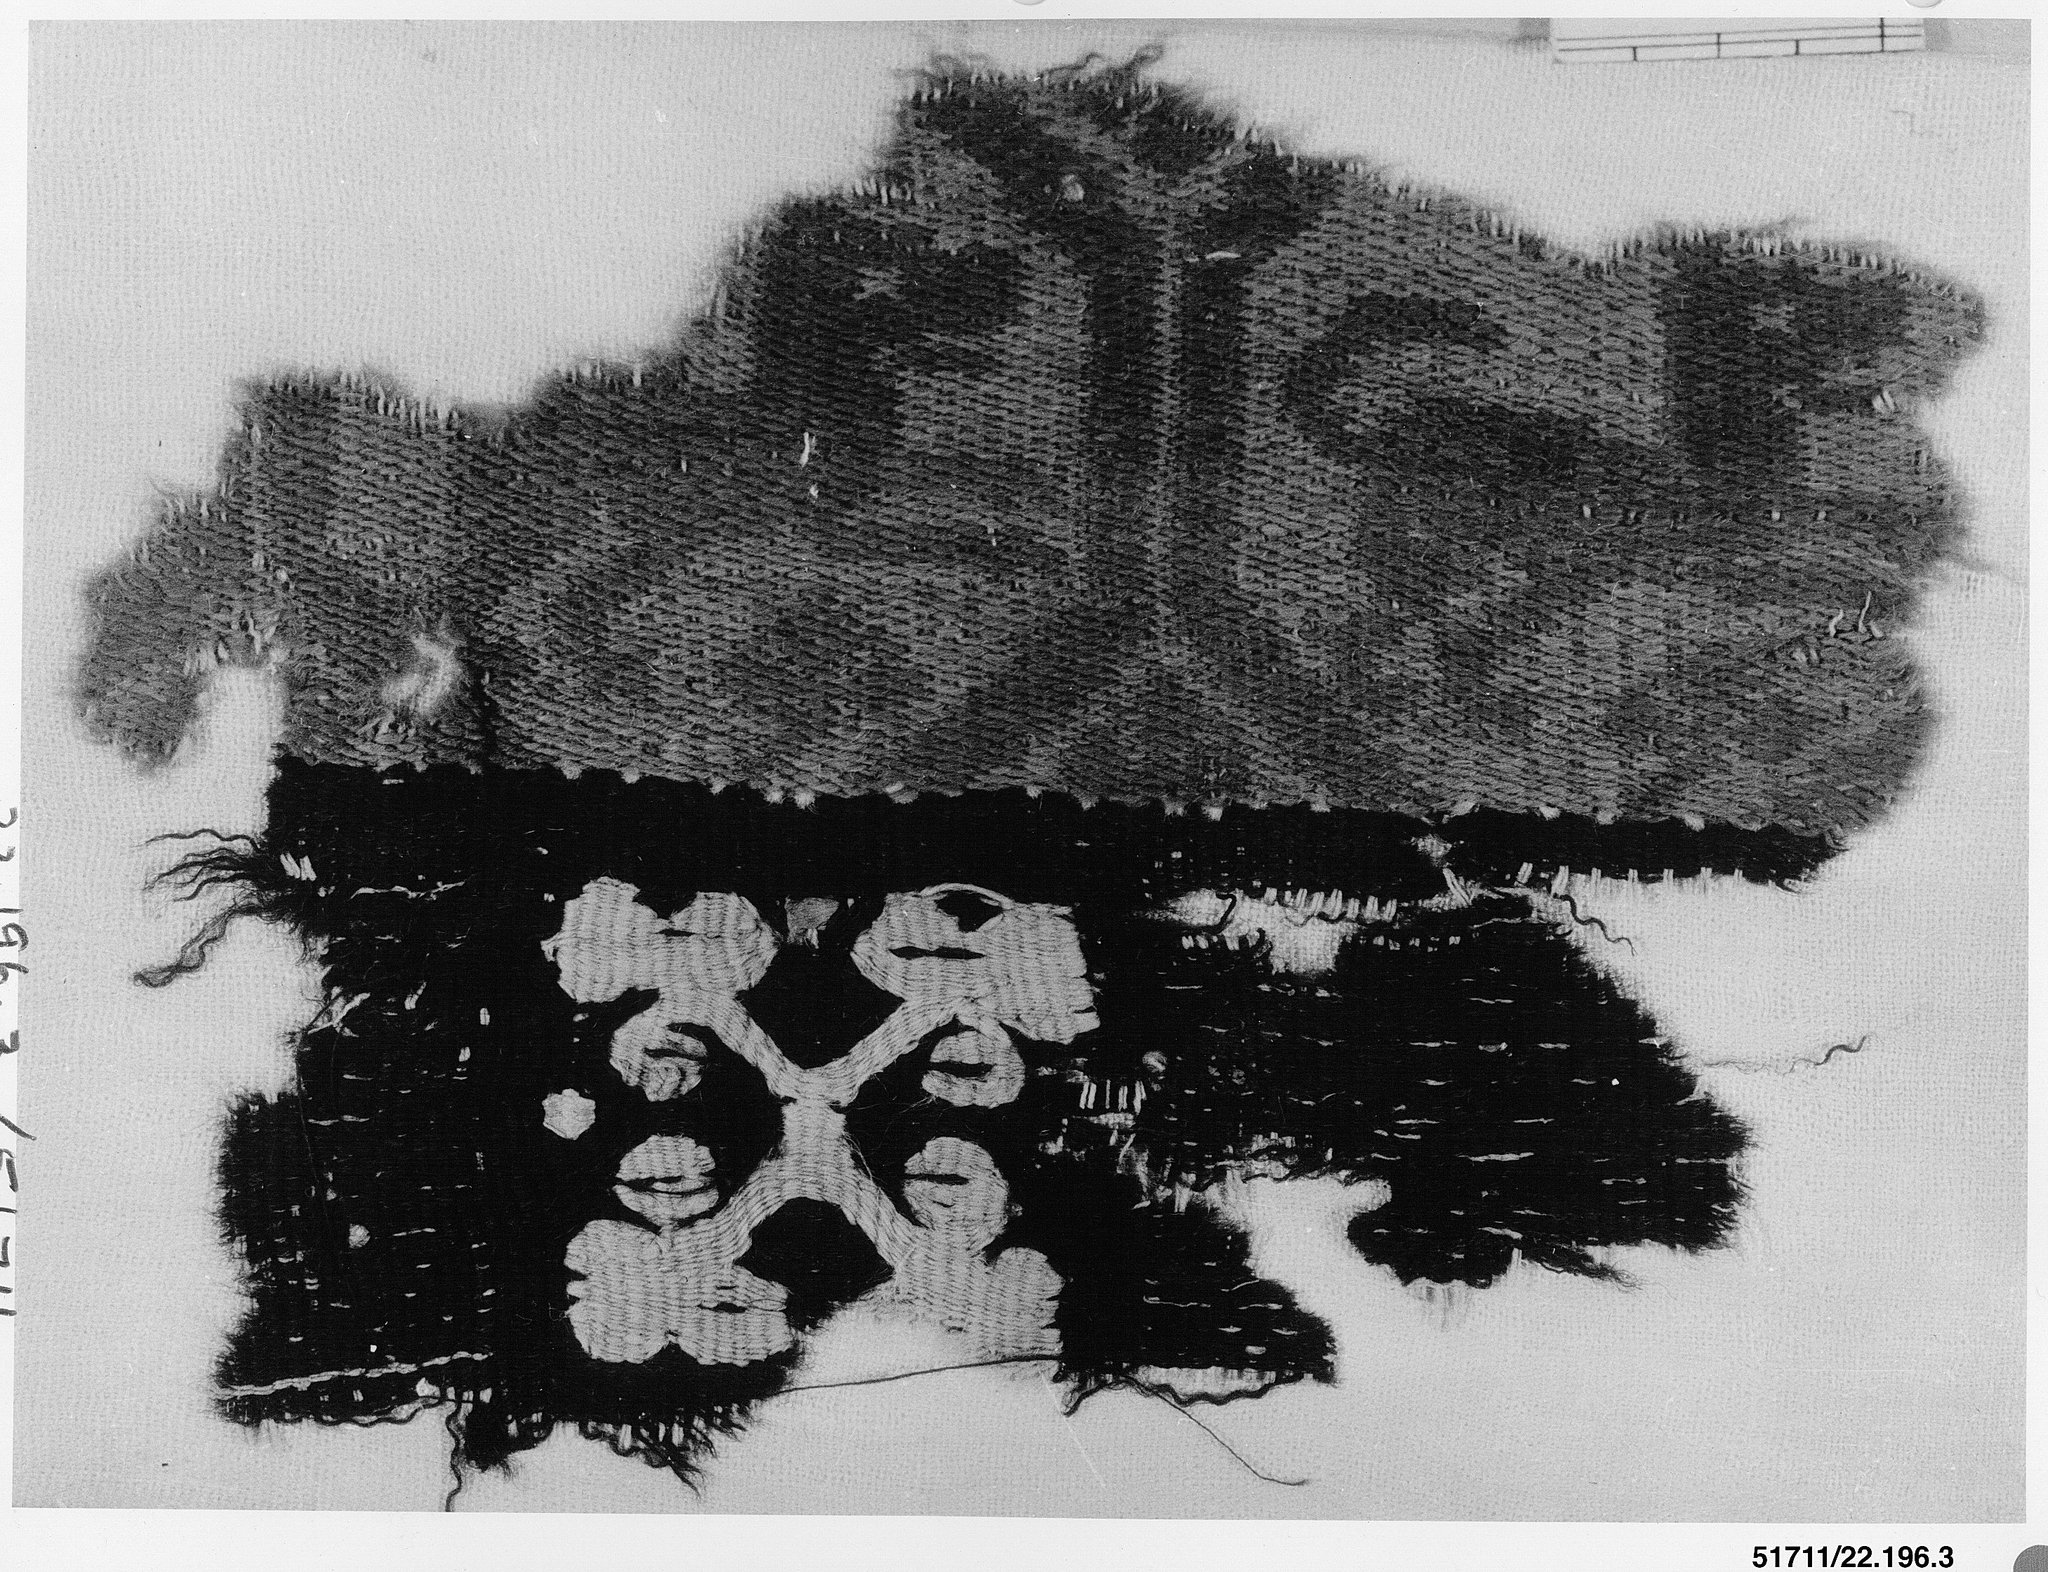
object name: fragment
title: Textile Fragment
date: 601-700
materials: wool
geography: egypt